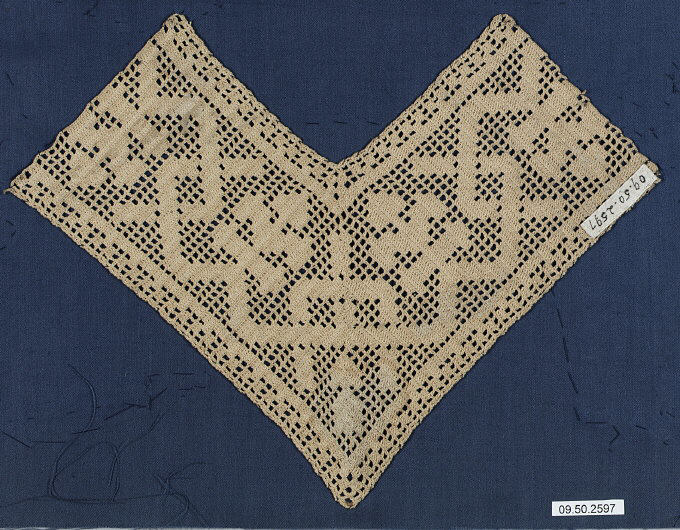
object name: border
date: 1801-1900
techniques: crochet